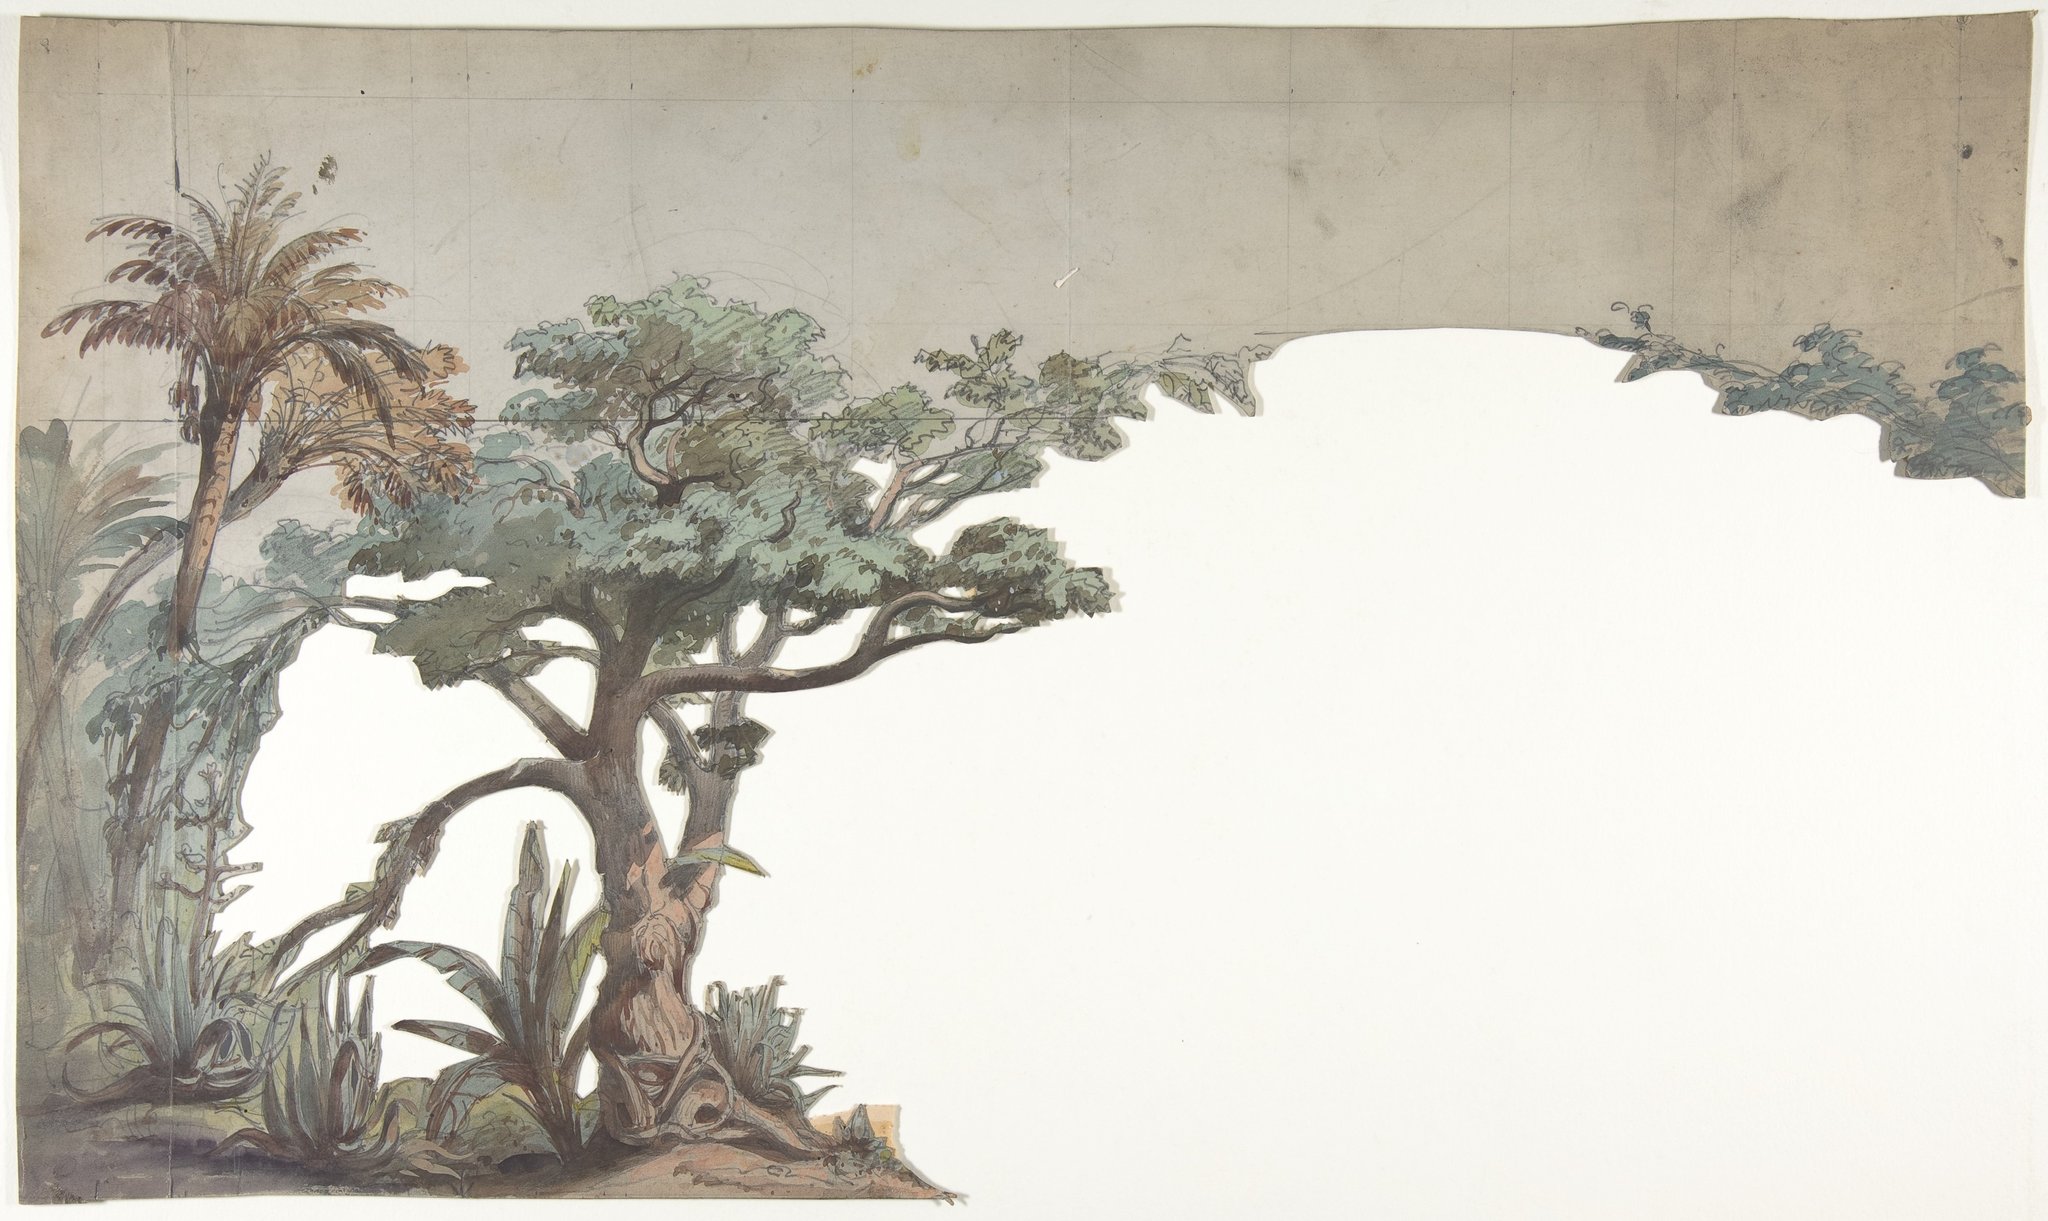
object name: drawing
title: Design for a Stage Set at the Opéra, Paris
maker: eugène cicéri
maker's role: artist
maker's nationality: french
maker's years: 1813-1890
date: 1828-1890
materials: gouache, graphite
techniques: brush, wash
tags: trees,stage design